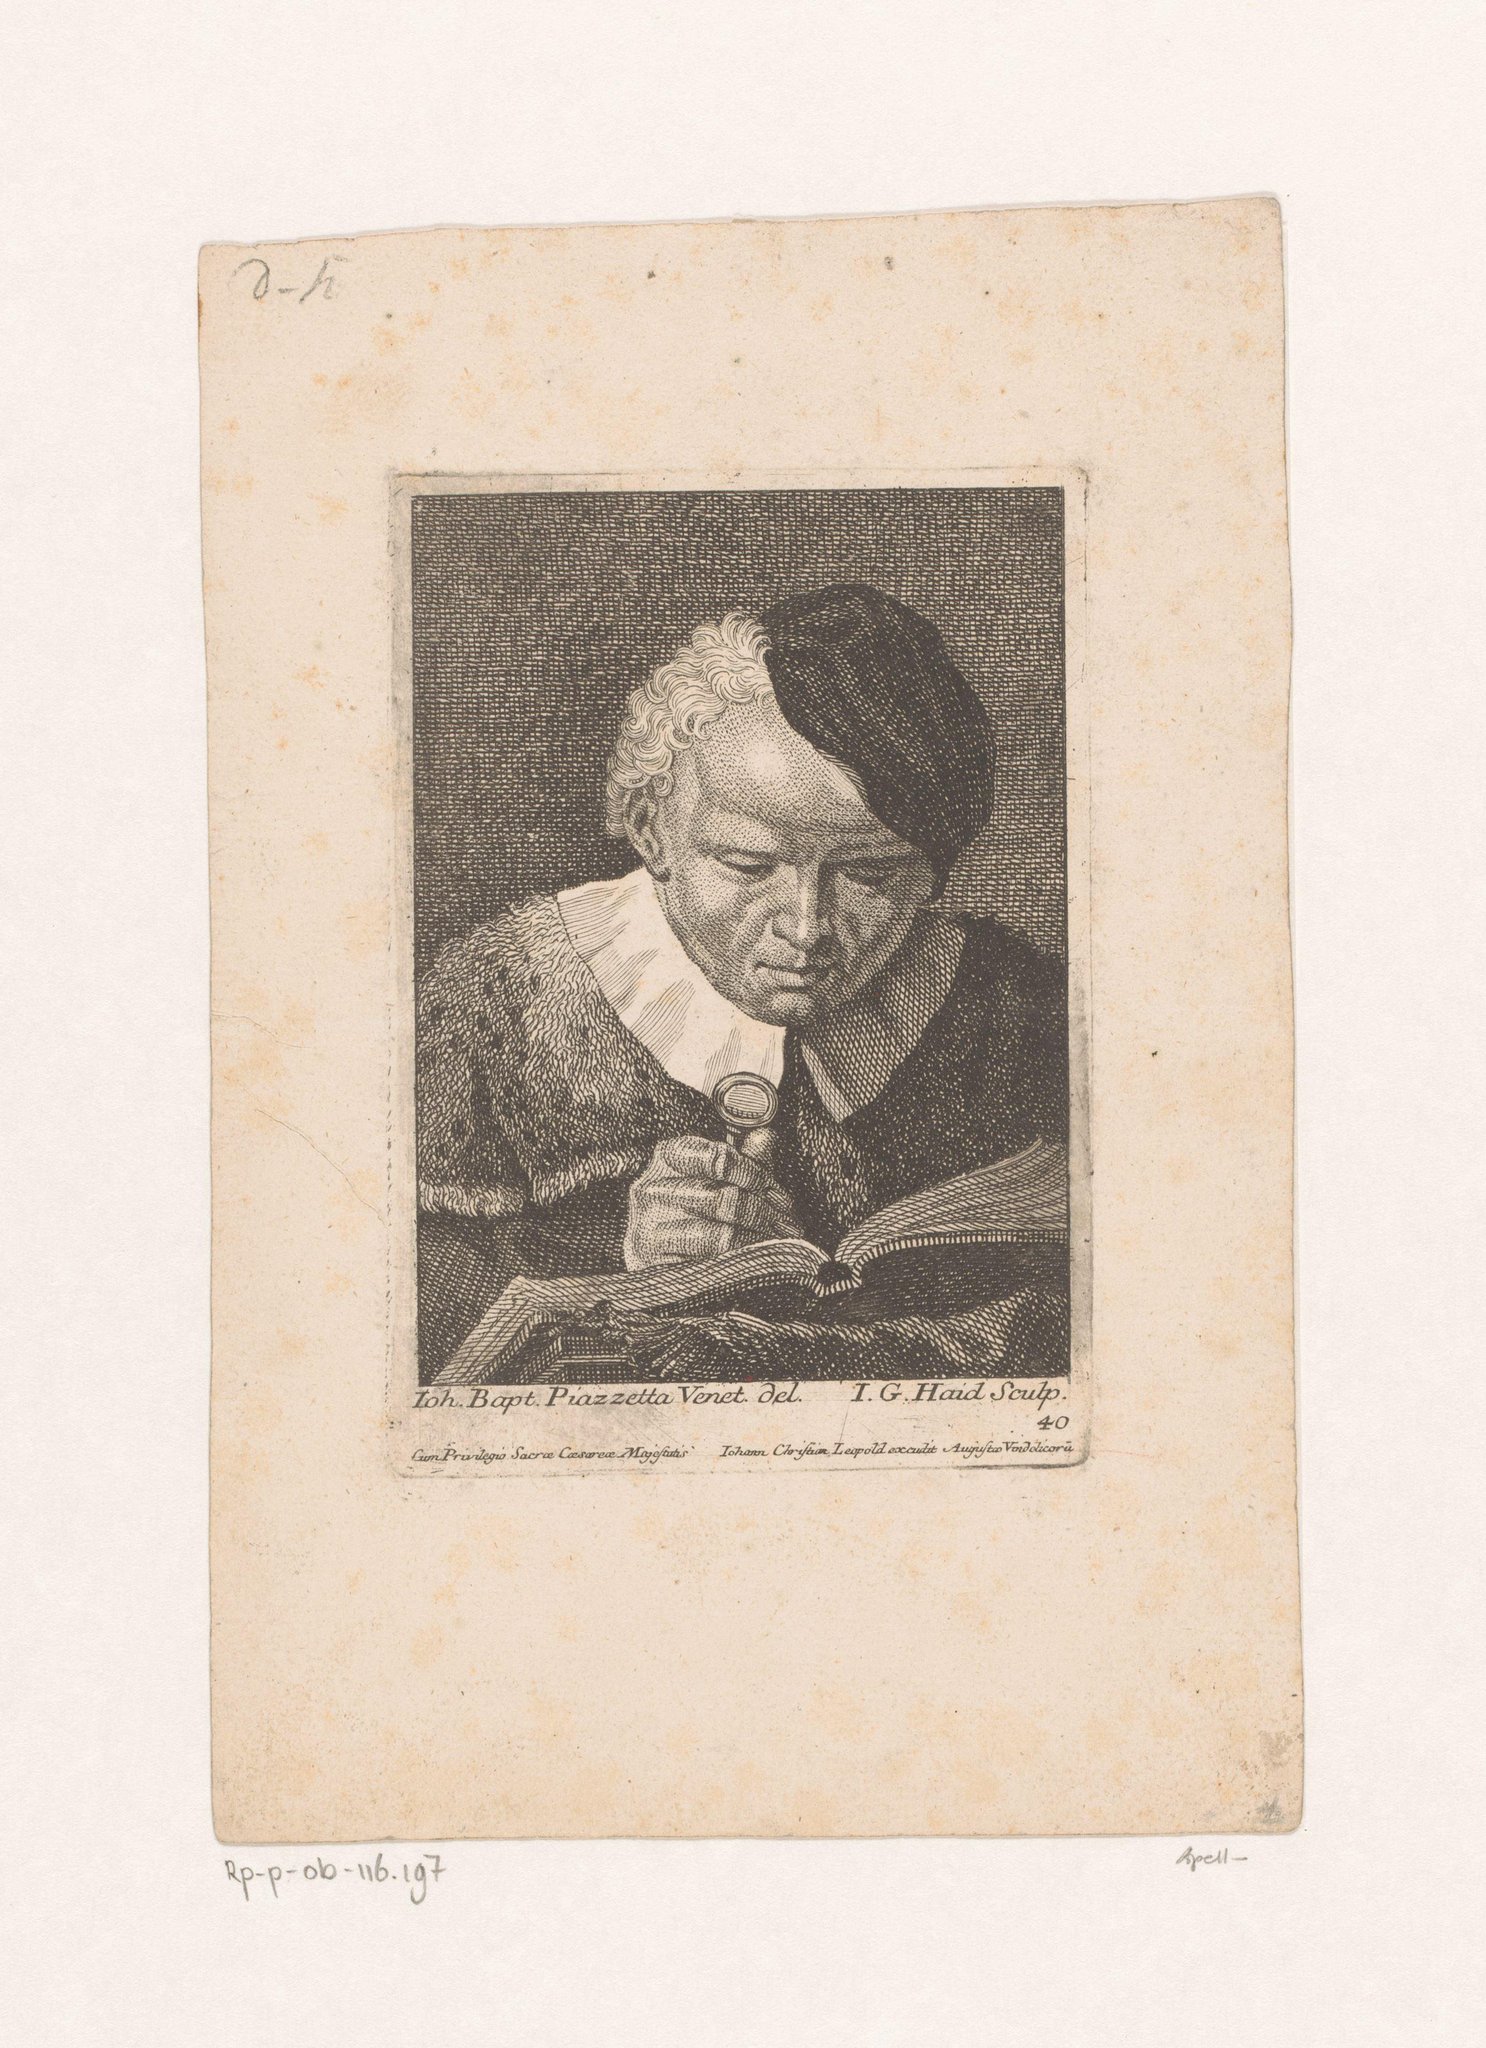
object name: print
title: Lezende man met vergrootglas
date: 1720-1776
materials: paper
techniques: etching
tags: reading, magnifying glass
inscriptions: collector's mark: Lugt 2228